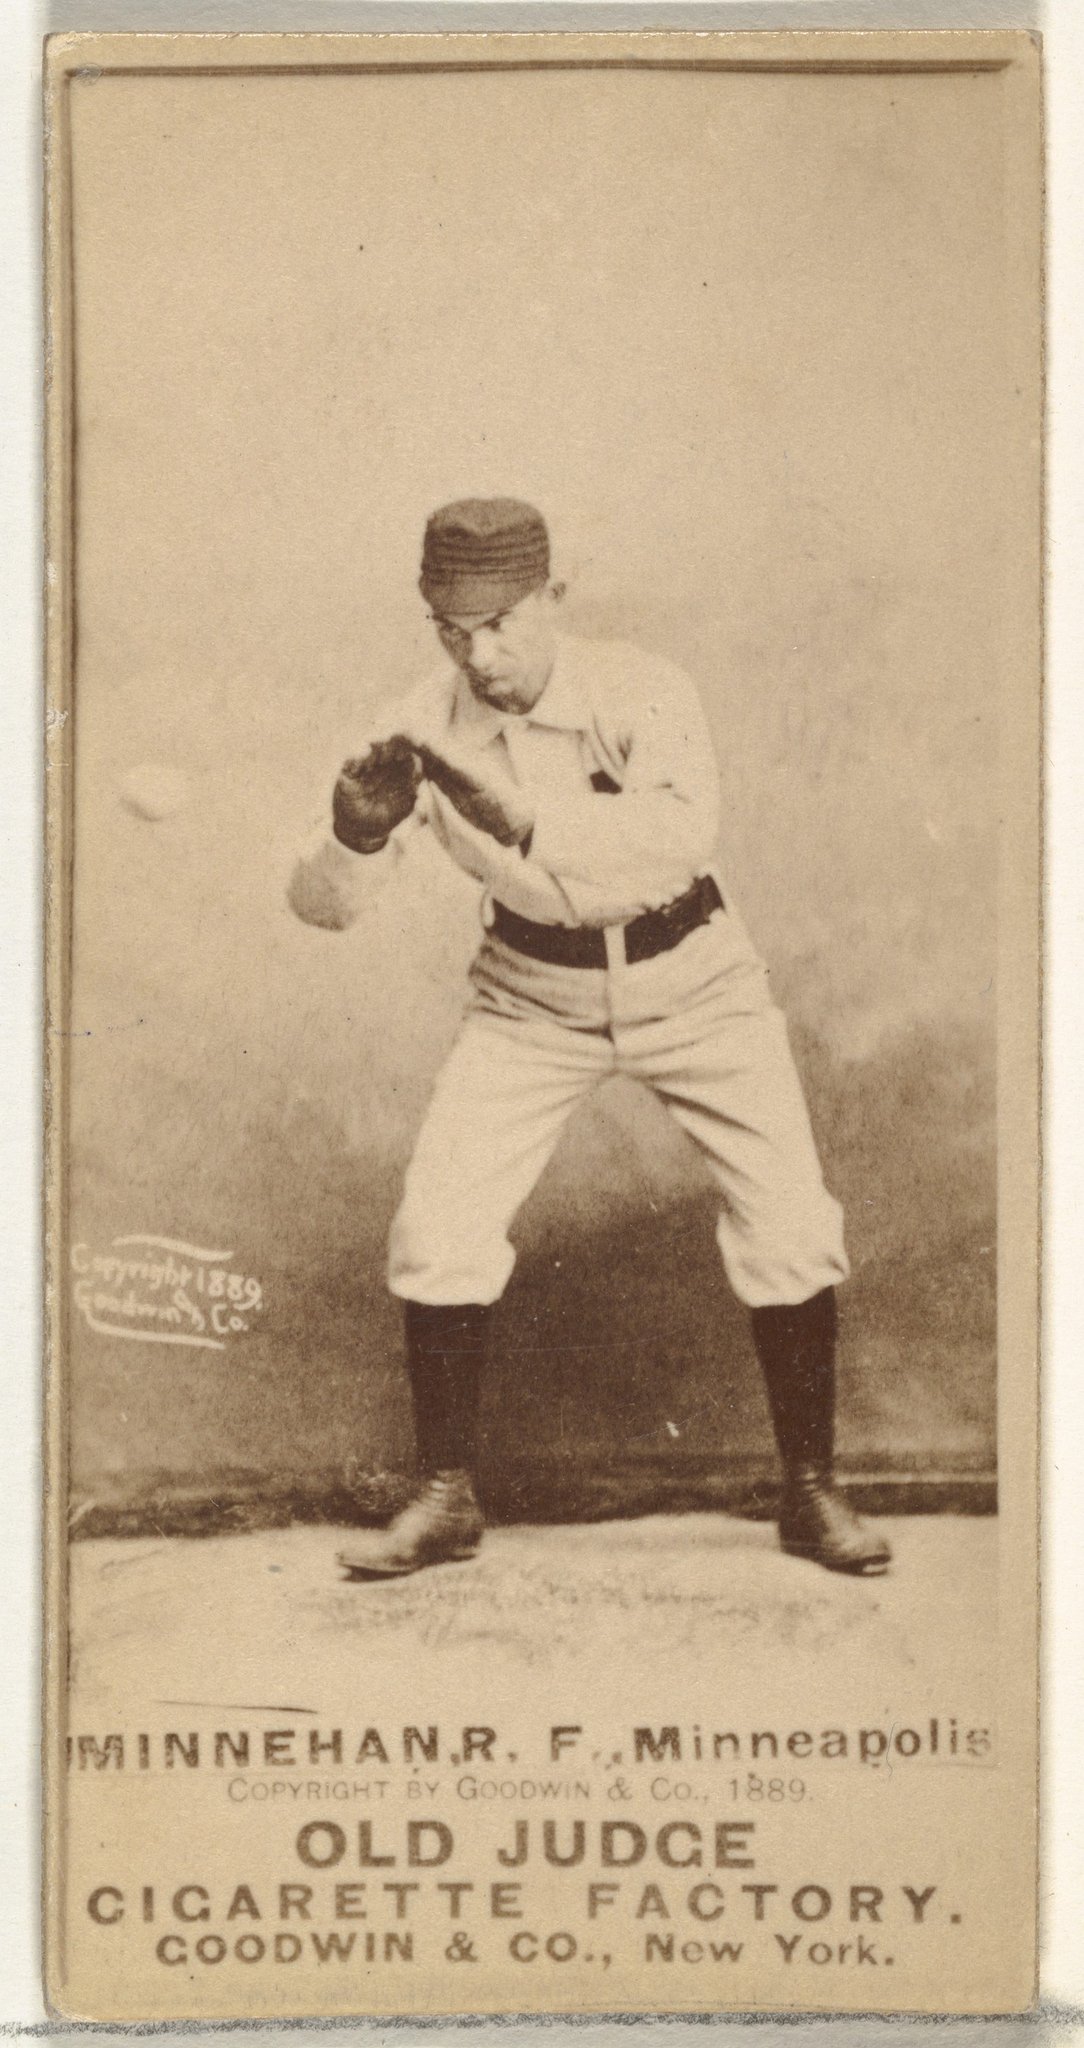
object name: baseball card, photograph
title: Daniel Joseph "Dan" Minnehan, Right Field, Minneapolis, from the Old Judge series (N172) for Old Judge Cigarettes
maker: goodwin & company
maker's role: publisher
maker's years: 1850-1950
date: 1889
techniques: albumen silver print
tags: men,portraits,baseball,athletes